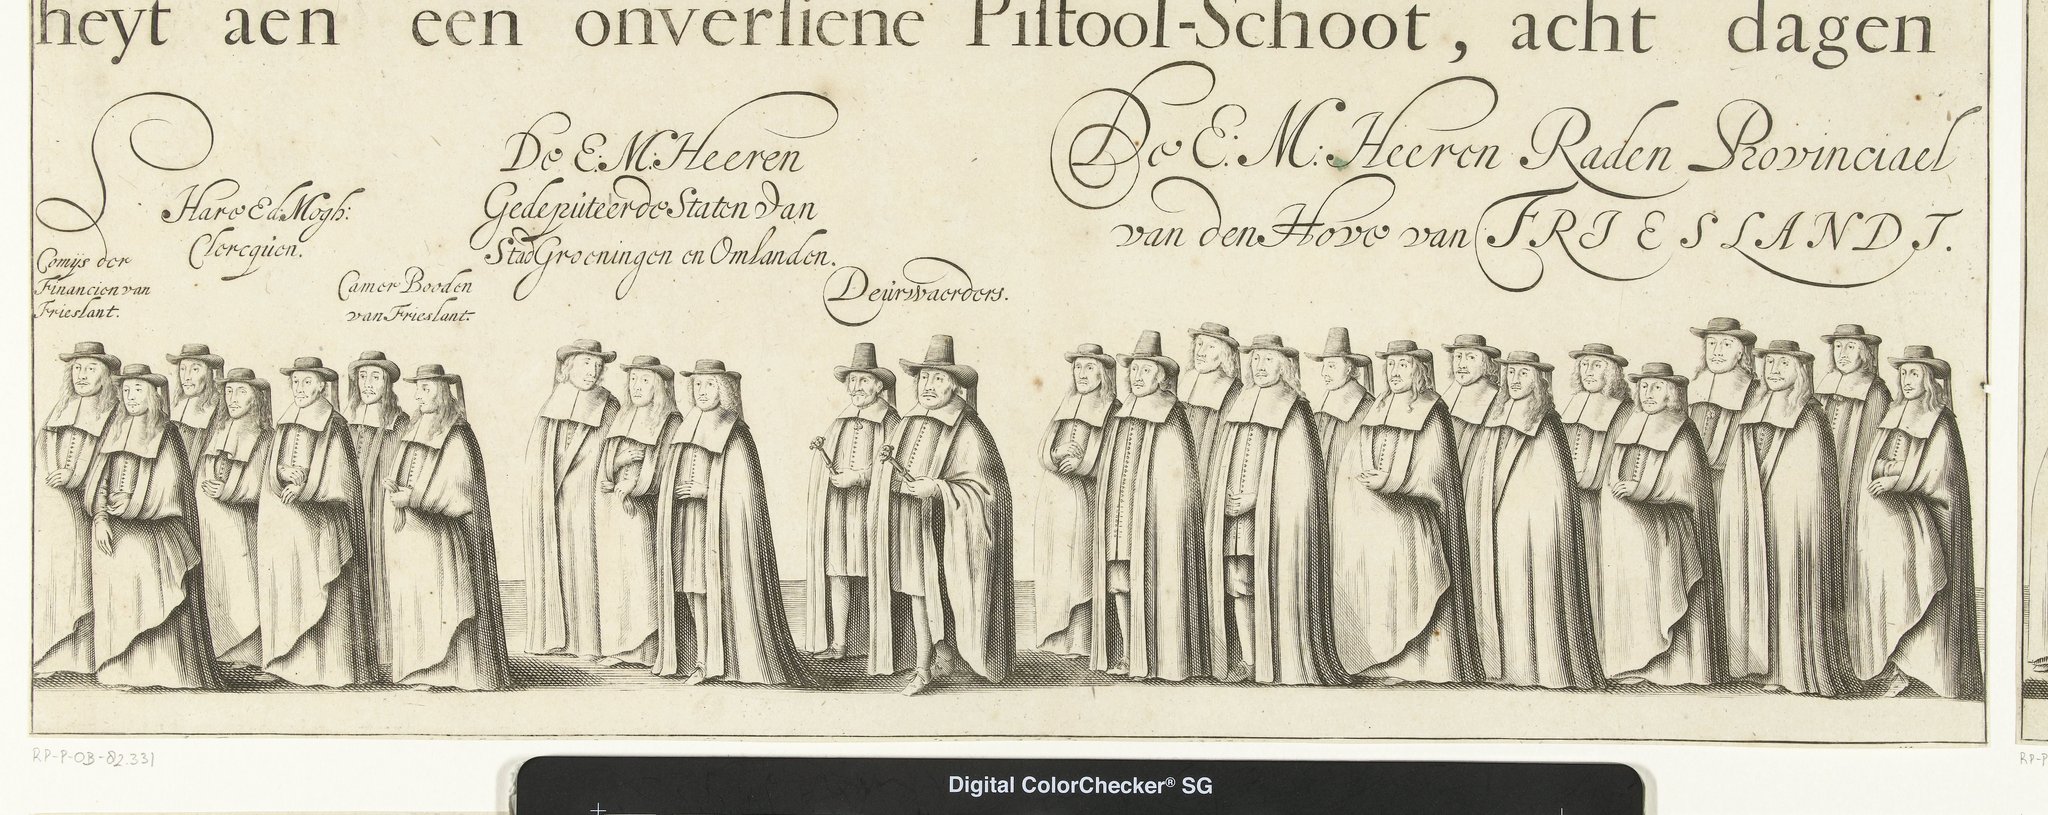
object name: print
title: Rouw-Staetelijcke Lijk-pracht in de Uyt-Vaert en Begraefenisse van het ont-zielde Lichaem van (...) Wilhelm Frederich (...) Overleden binnen Leeuwarden (...) den een-en-twintichsten October, MDCLXIV. en aldaer in 't Choor van de Jacobijner Kerck, den vyfthienden december MDCLXIV. Oude Stijl (...)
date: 1666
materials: paper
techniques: engraving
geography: leeuwarden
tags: arnhem, cortege, funeral procession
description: Begrafenisoptocht van Willem Frederik, graaf van Nassau-Dietz, in Leeuwarden op 6 januari 1665. Deel van de begrafenisstoet. Plaat nr. 19 in een ensemble van 24 (van de 25) ongemonteerde genummerde platen (zonder tekstbladen) die samen een lange fries vormen.